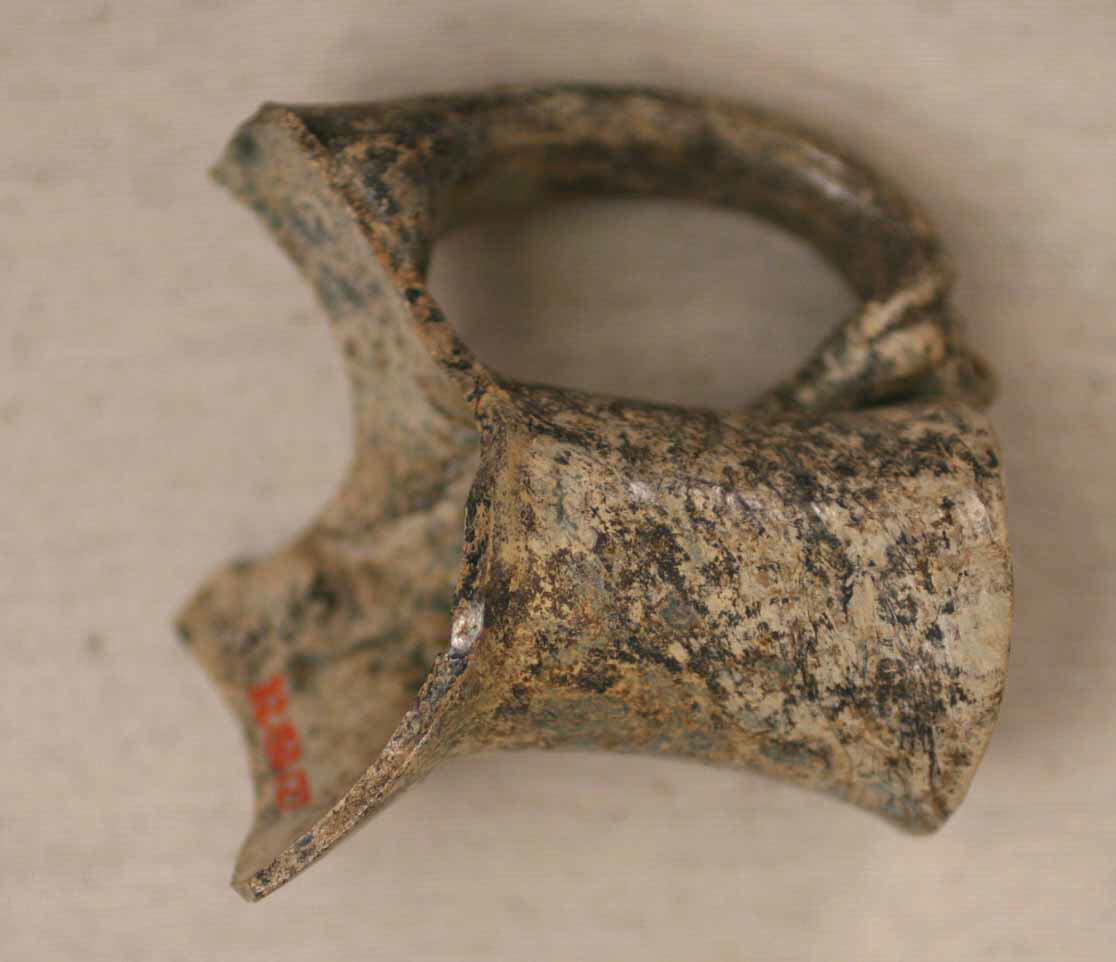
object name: fragment of an ewer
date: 701-900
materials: glass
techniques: glassblowing, tooling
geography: iraq